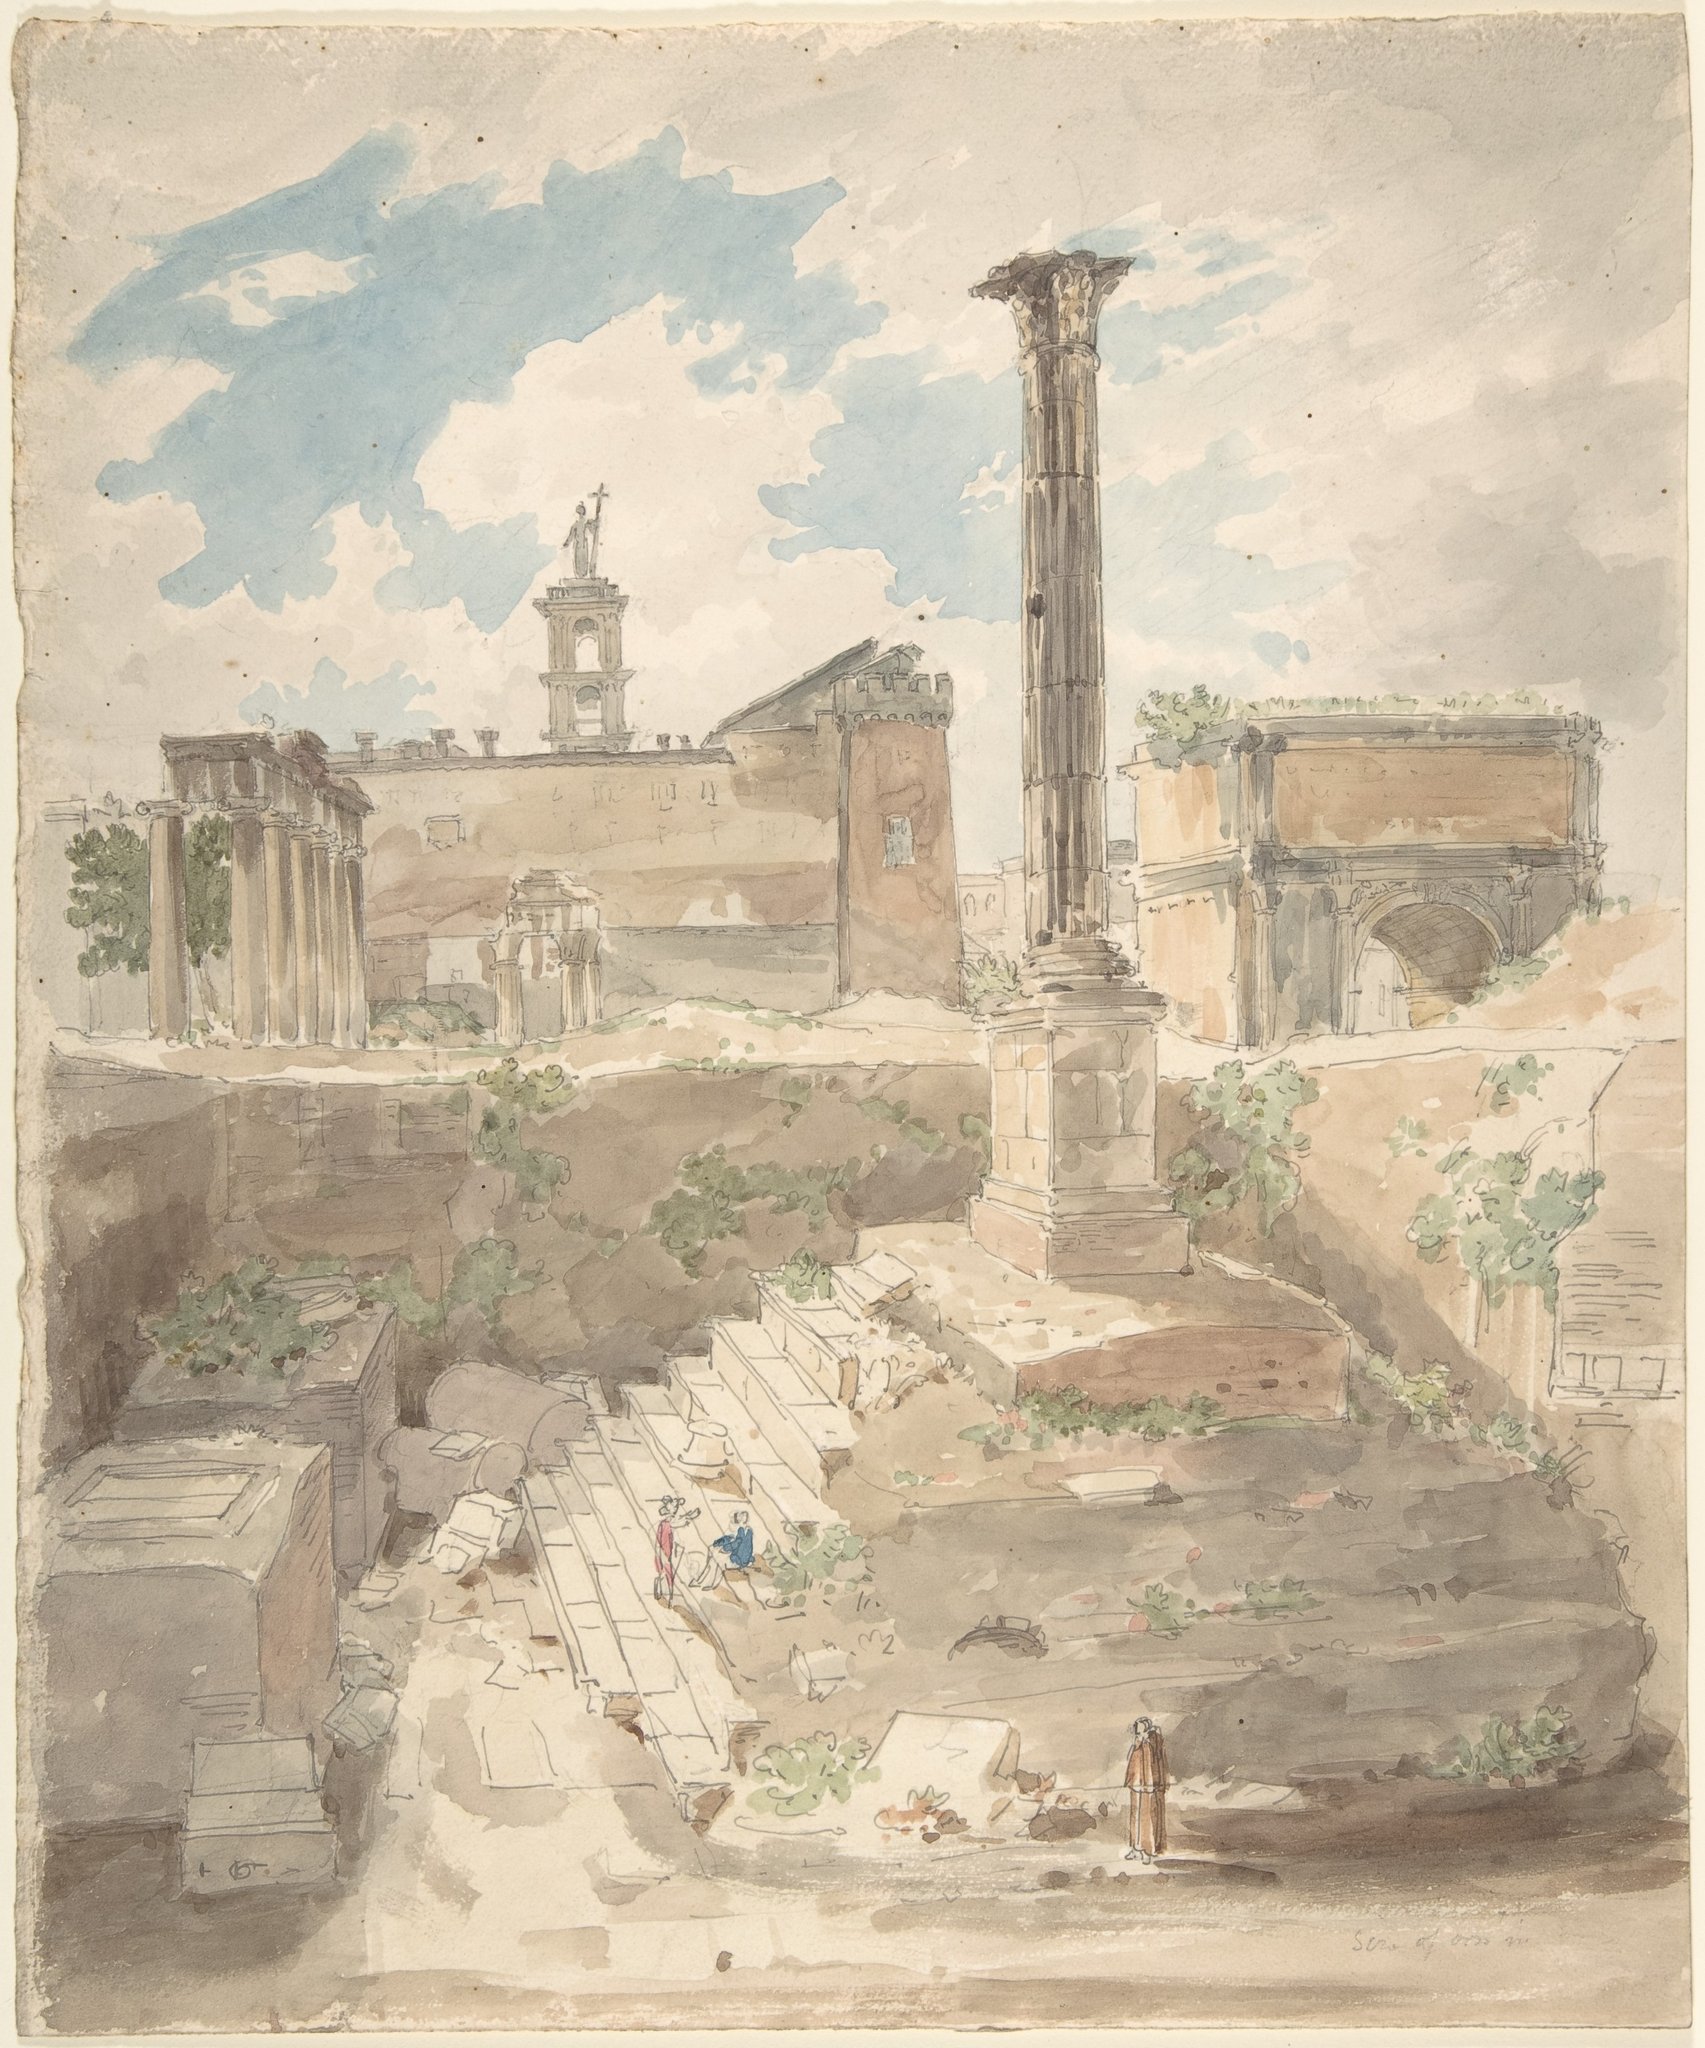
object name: drawing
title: View of the Roman Forum, unexcavated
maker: sir charles barry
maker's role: artist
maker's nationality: british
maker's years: 1795-1860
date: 1840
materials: graphite, watercolor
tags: towers,ruins,rome